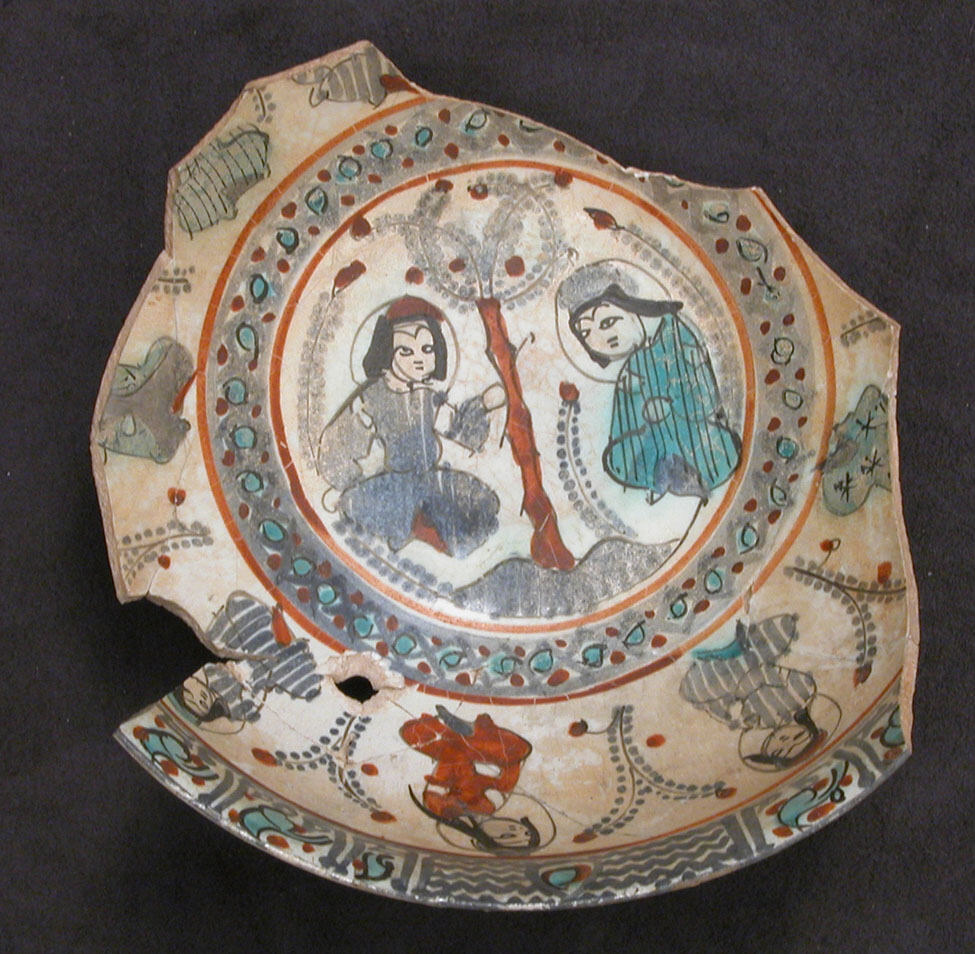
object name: fragment of a bowl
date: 1101-1300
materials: stonepaste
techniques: overglaze, painting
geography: iran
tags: human figures